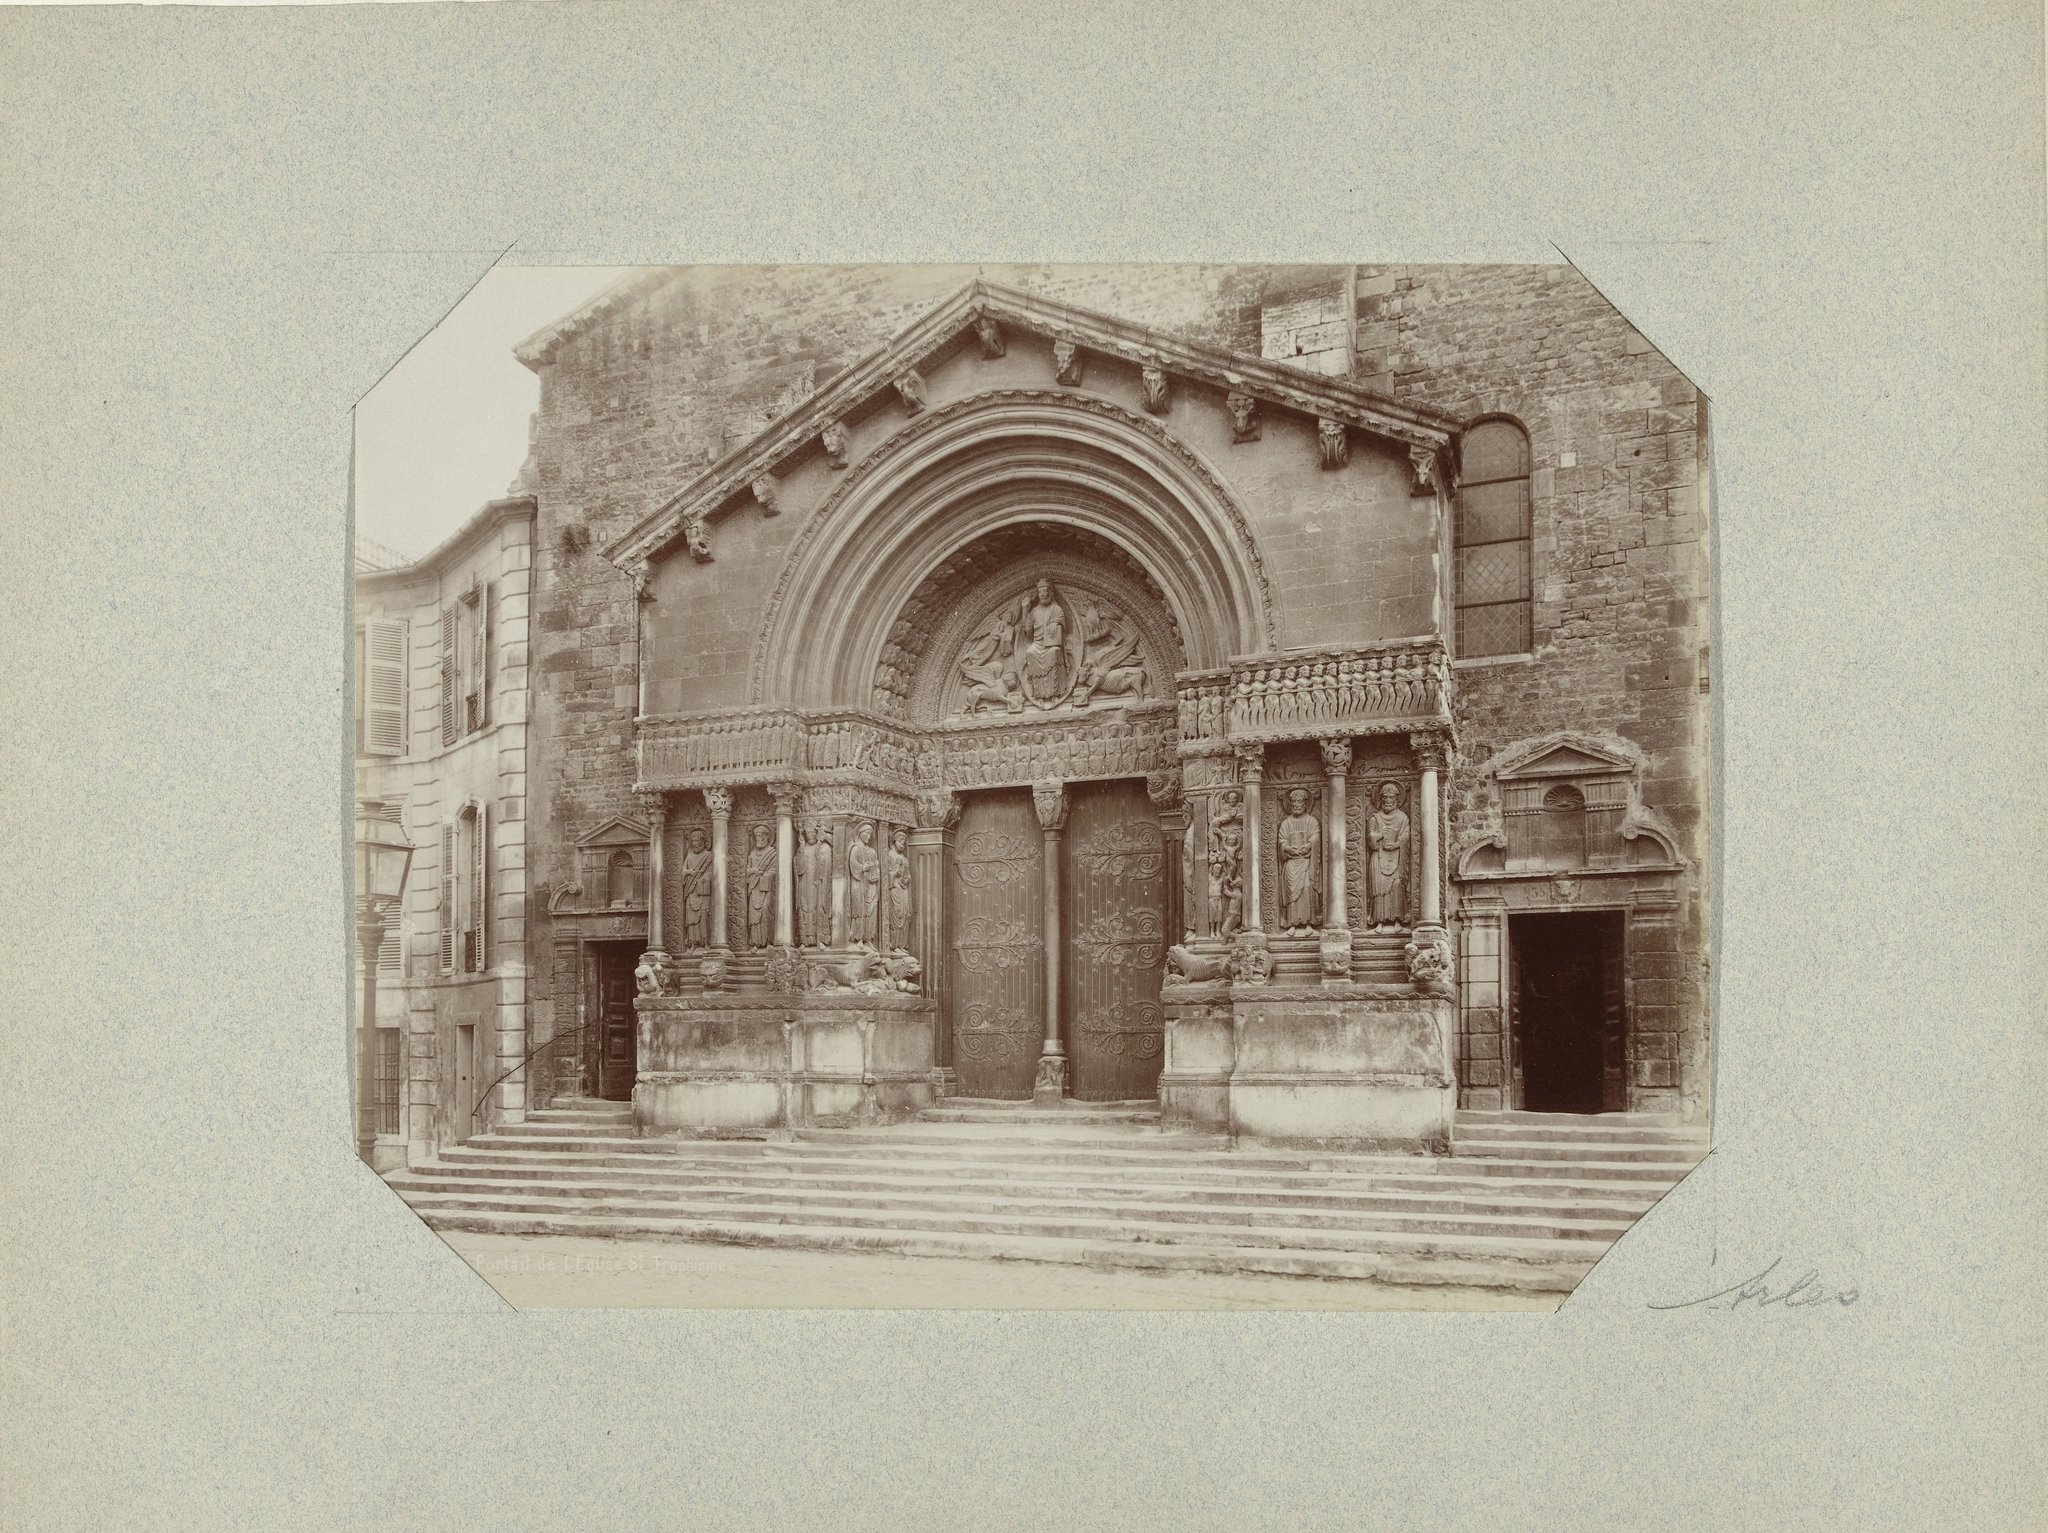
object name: photograph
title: Arles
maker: Anonymous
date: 1851-1900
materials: cardboard, paper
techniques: albumen print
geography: arles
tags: parts of church exterior and annexes: portal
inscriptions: inscription: ‘Arles’, stamp: ‘14’